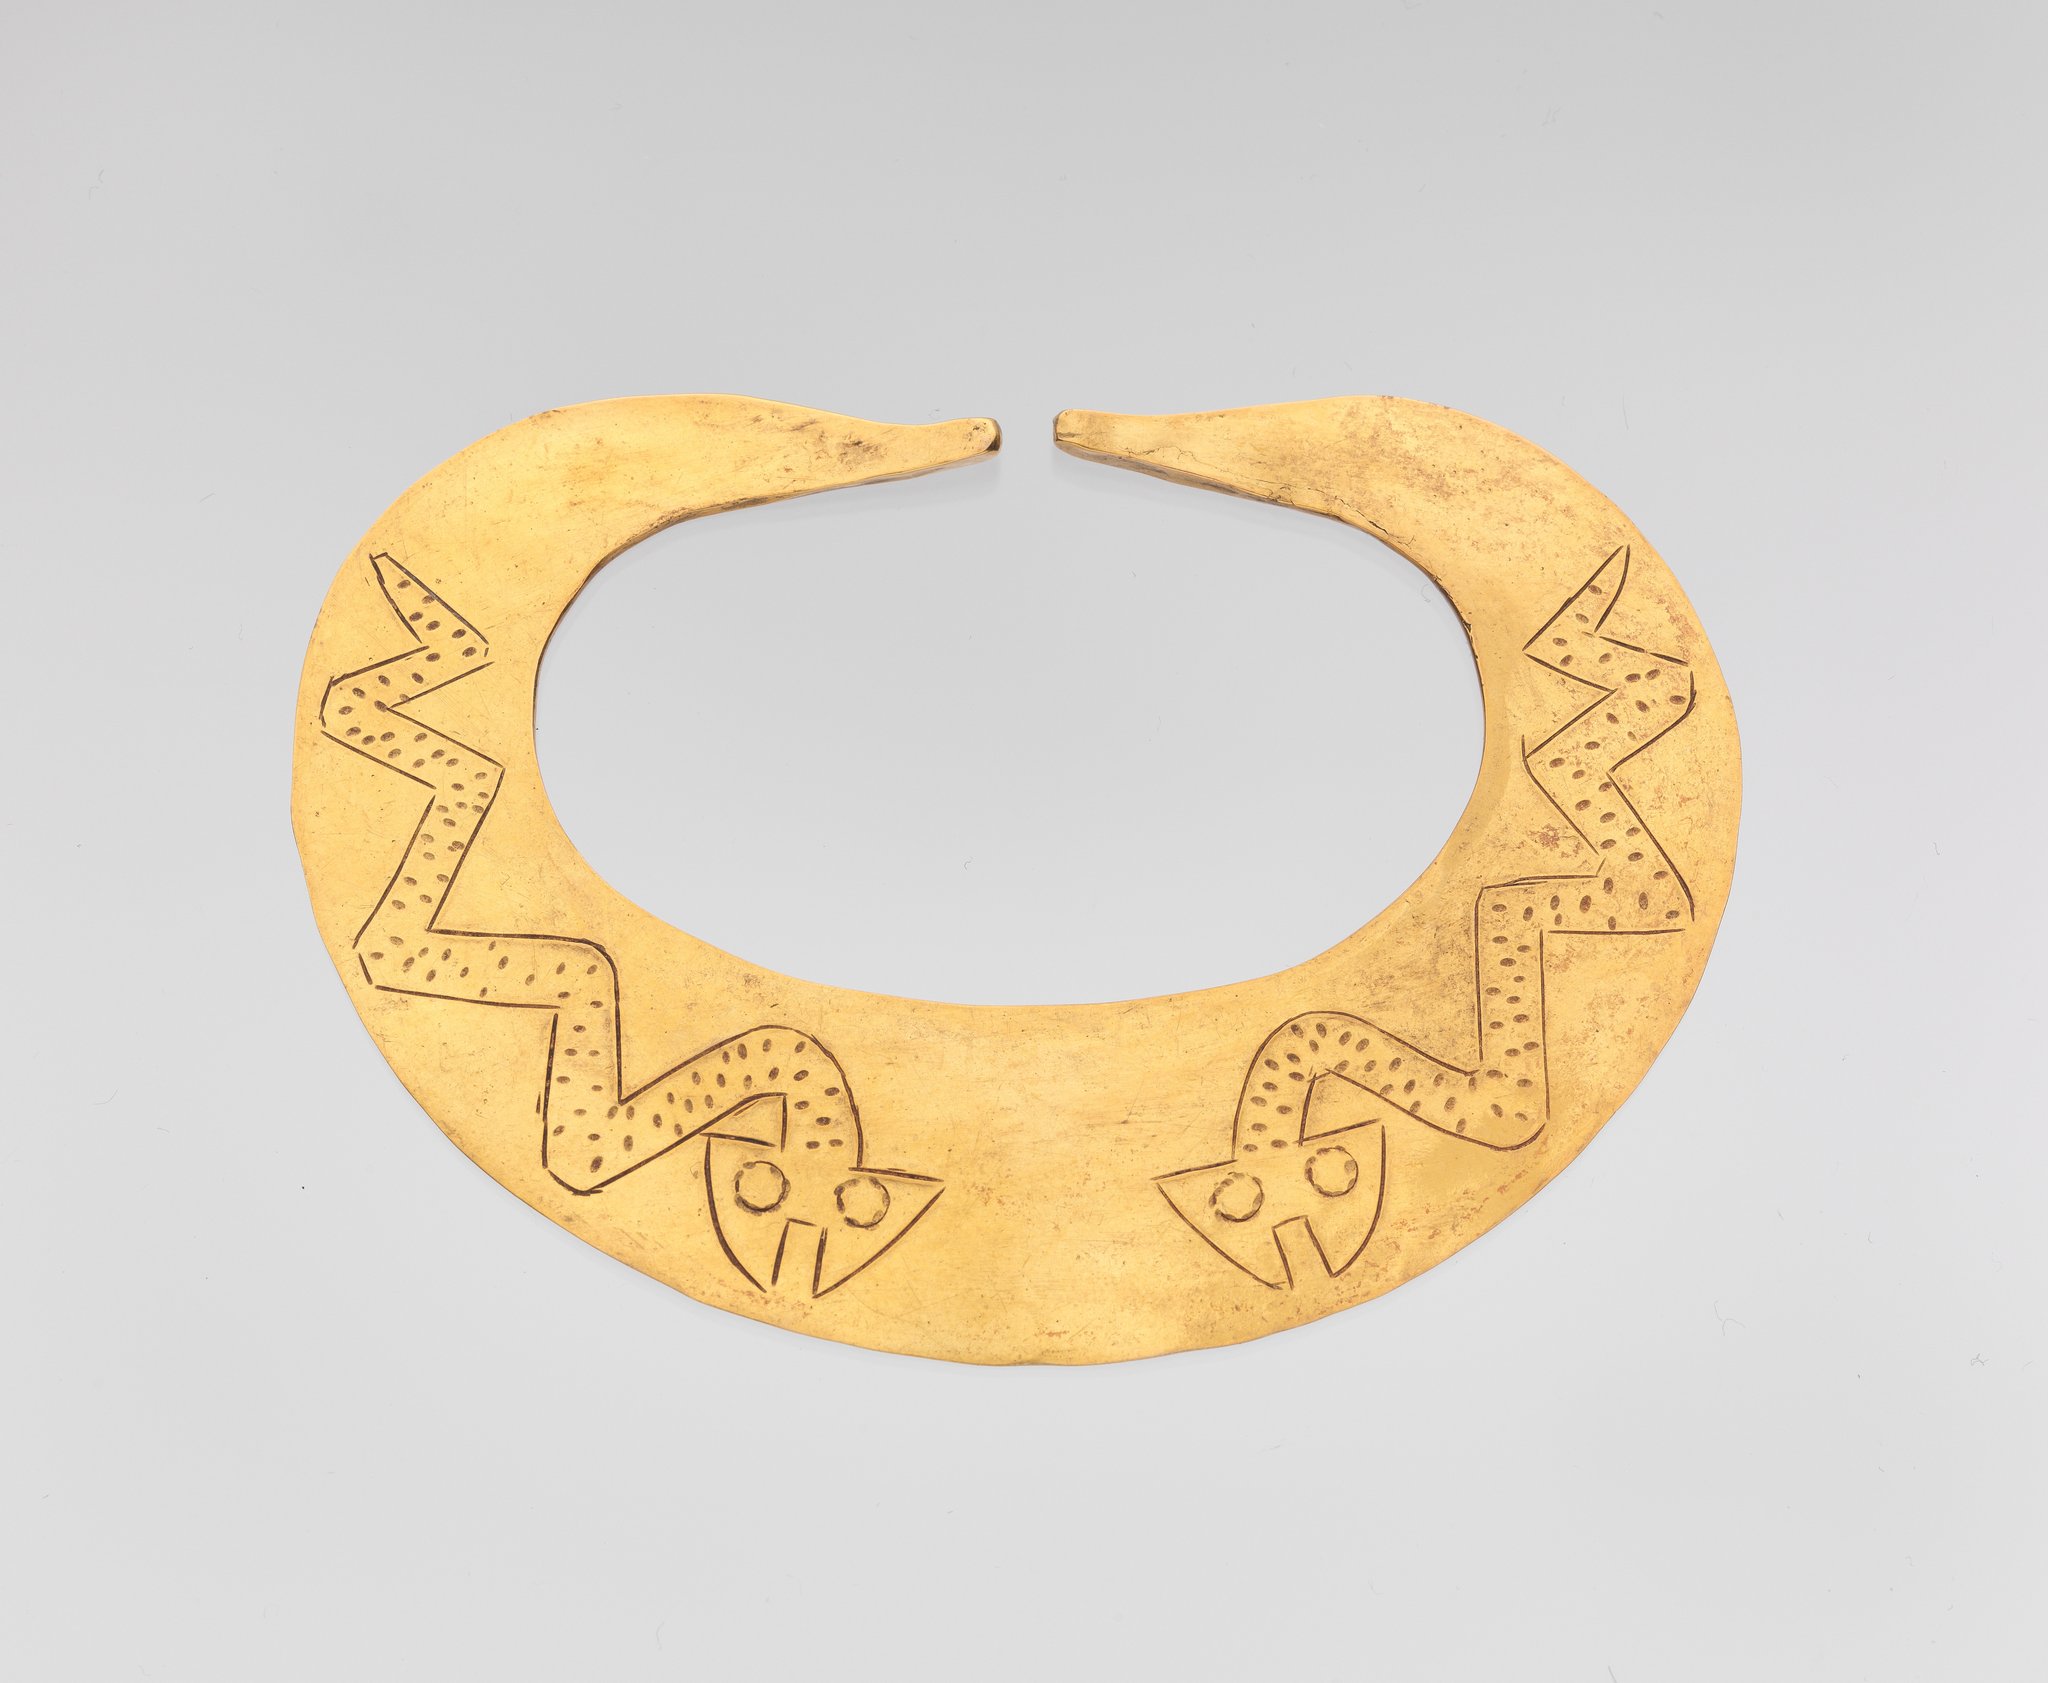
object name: nose ornament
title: Nose Ornament with Snakes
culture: ecuador or peru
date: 200 BCE-200 CE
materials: gold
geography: ecuador or peru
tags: snakes